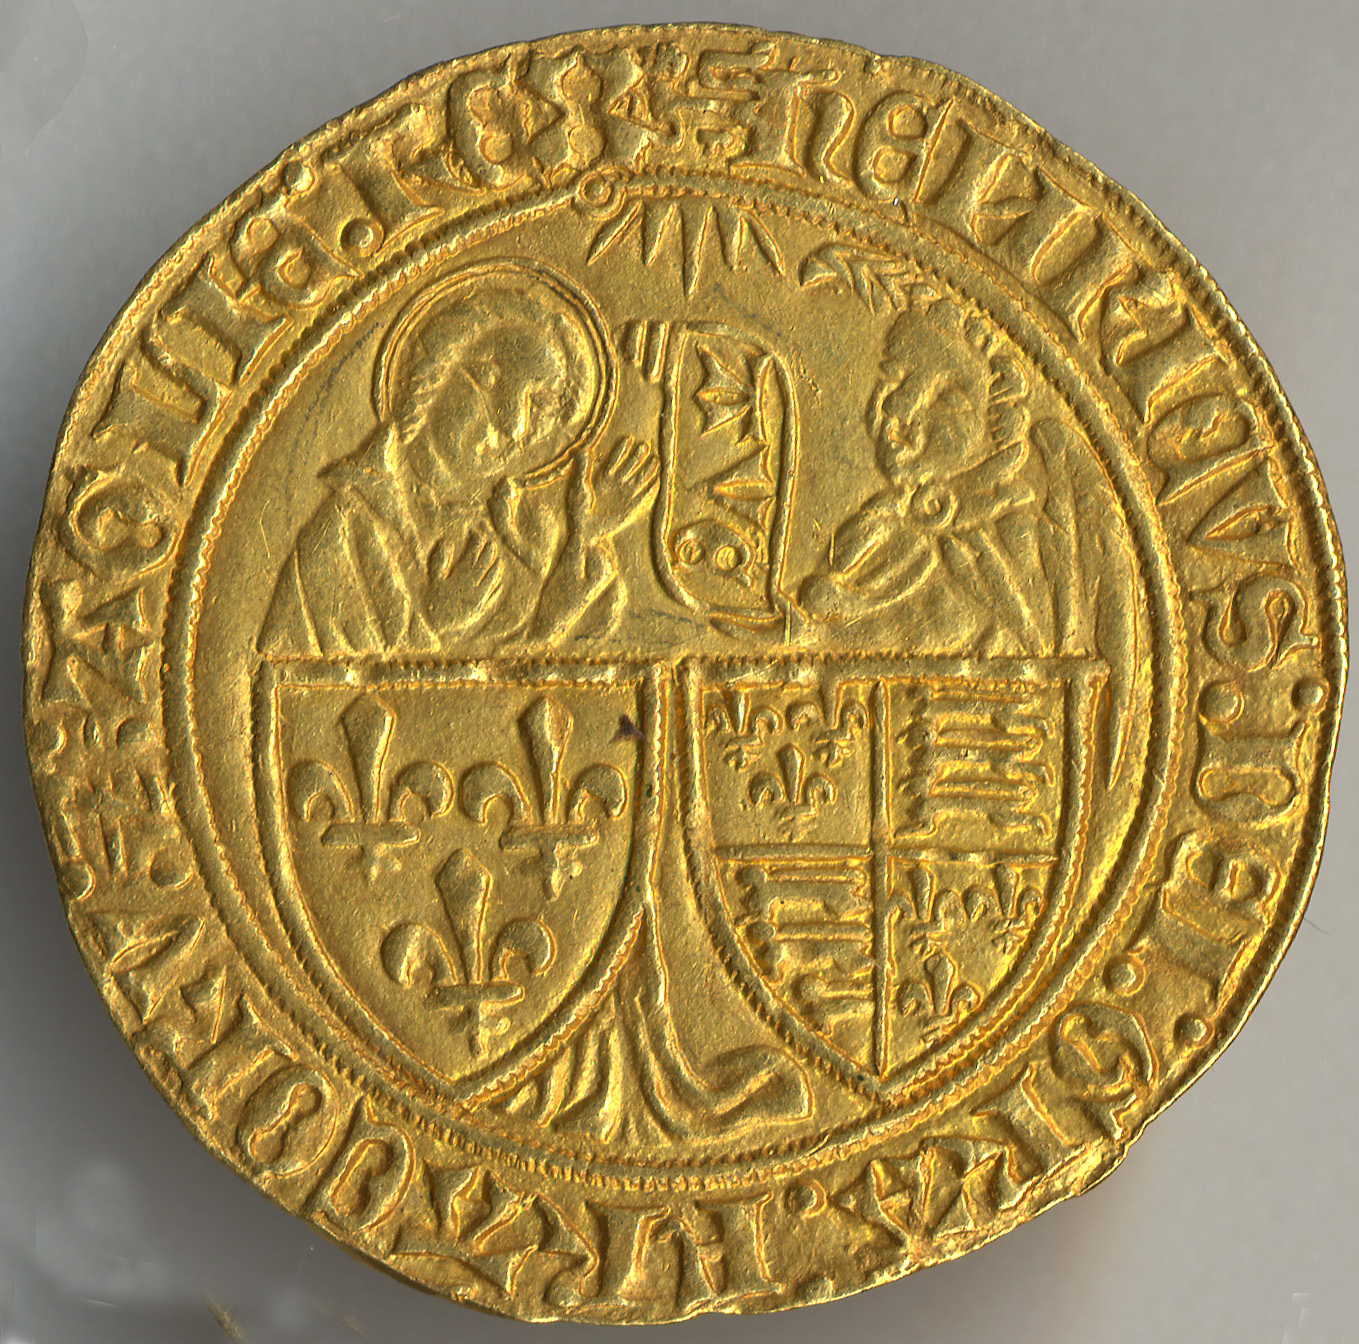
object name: coin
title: Quarter Noble of Henry VI (1422-61)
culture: british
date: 1401-1500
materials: gold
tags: human figures,coins,insignia